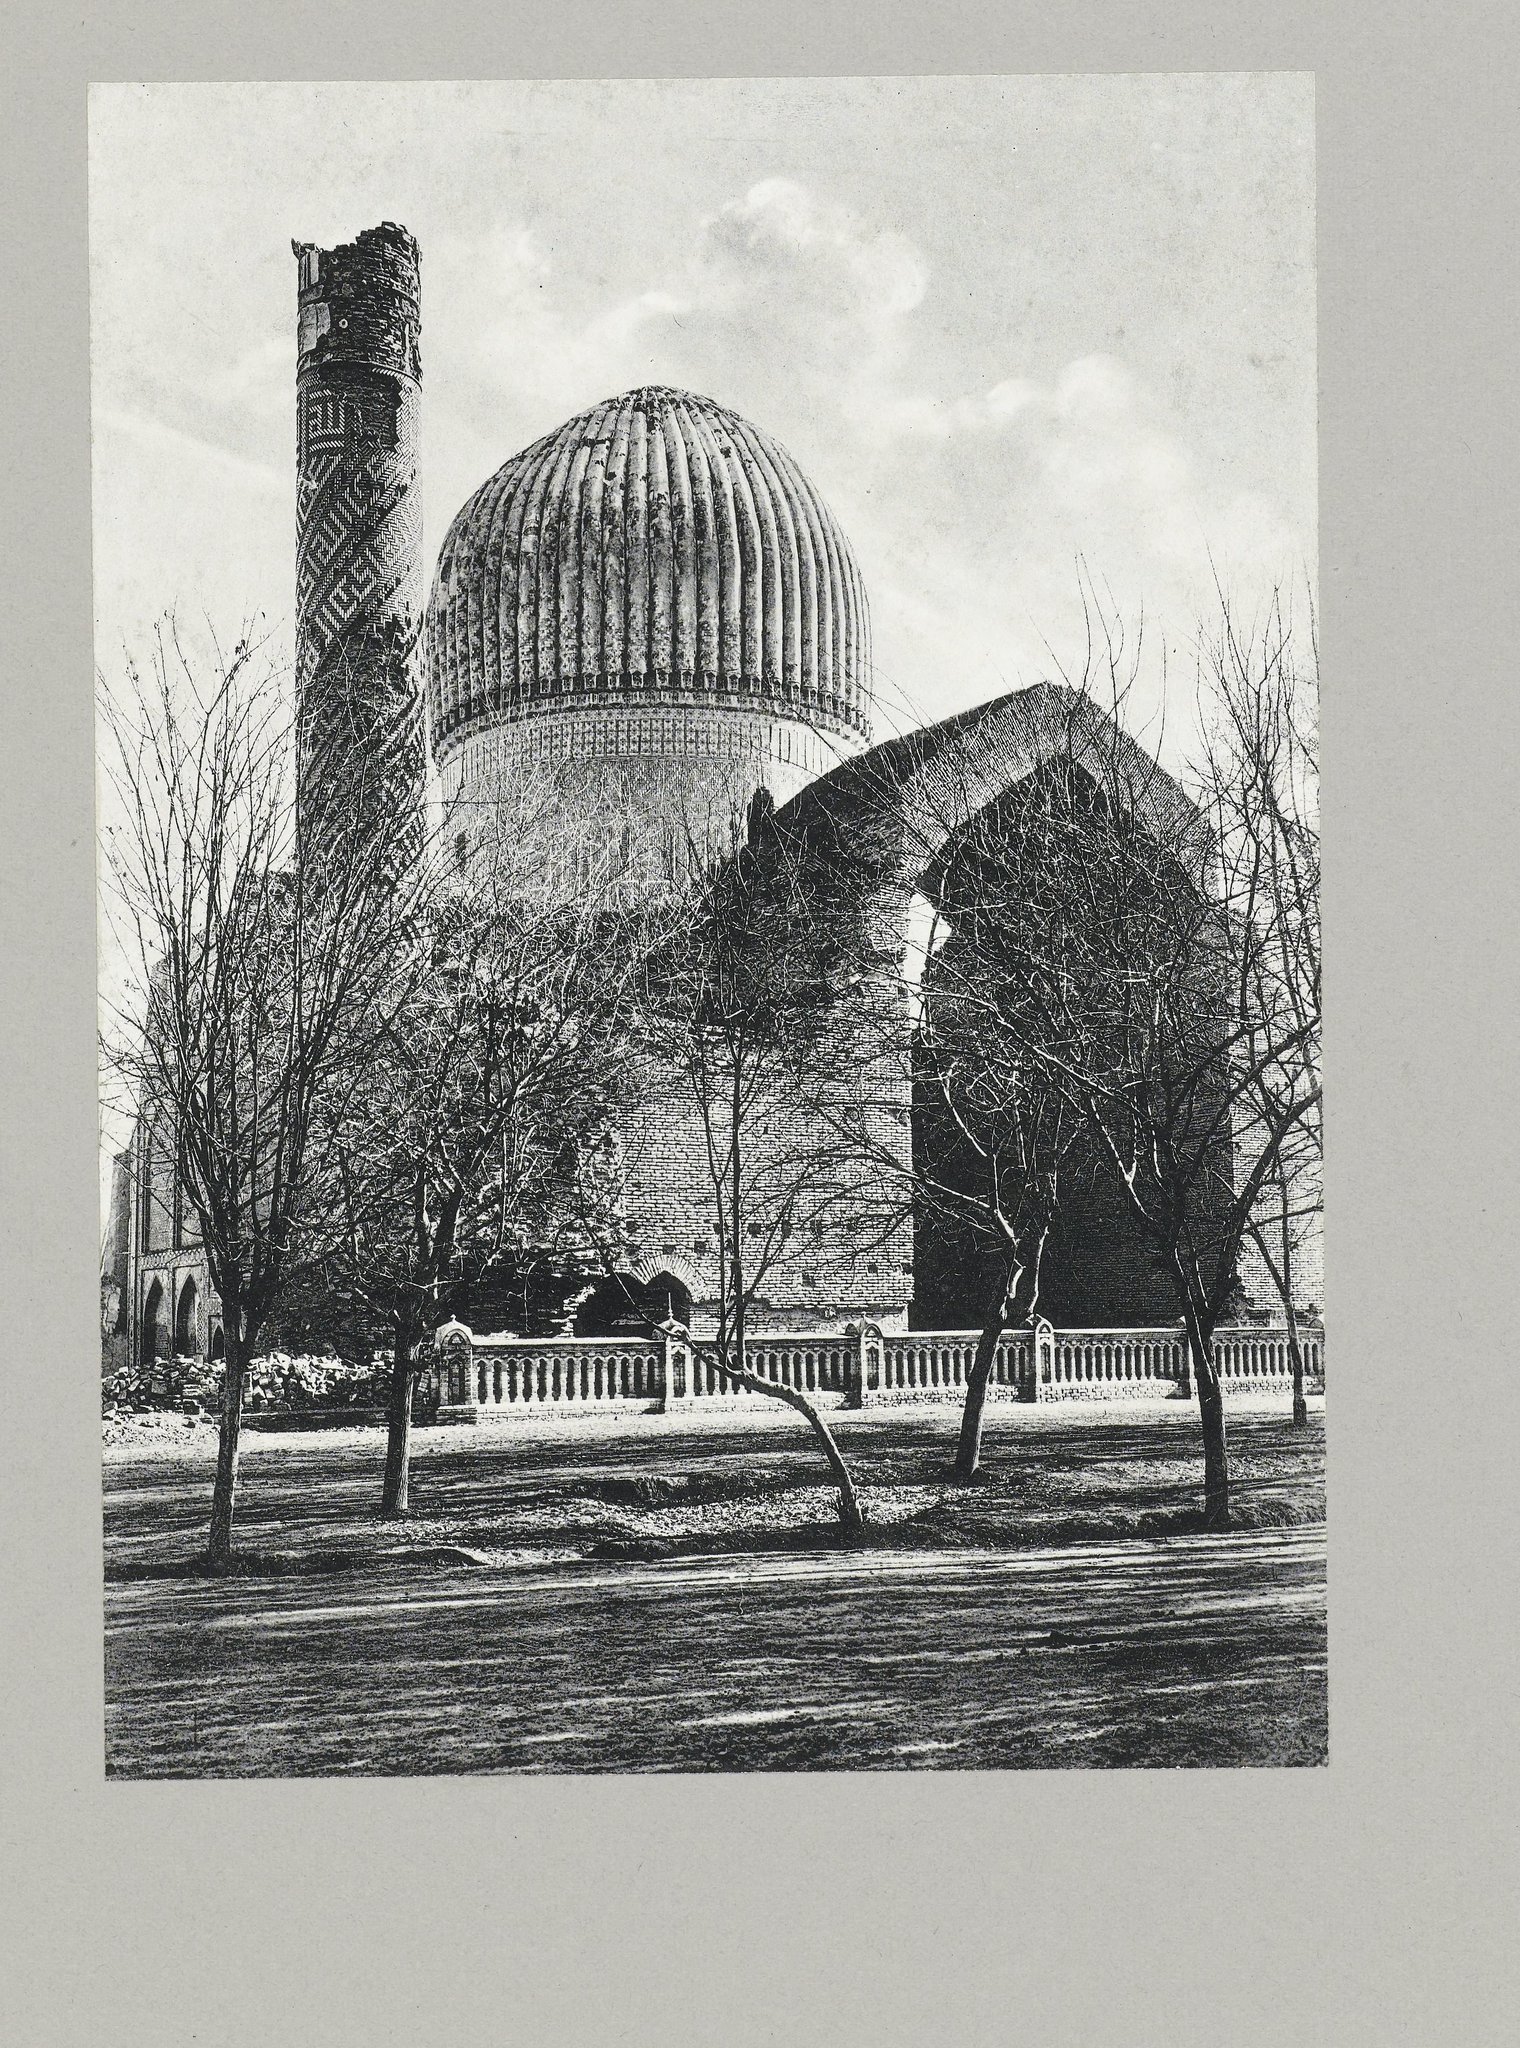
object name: photomechanical print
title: Mausoleum van Timur te Samarkand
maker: Anonymous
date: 1895-1915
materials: cardboard, paper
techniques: photograph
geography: samarqand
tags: samarqand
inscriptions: annotation: ‘6. Mausoleum van Timur (Tamer) te Samerkand.’